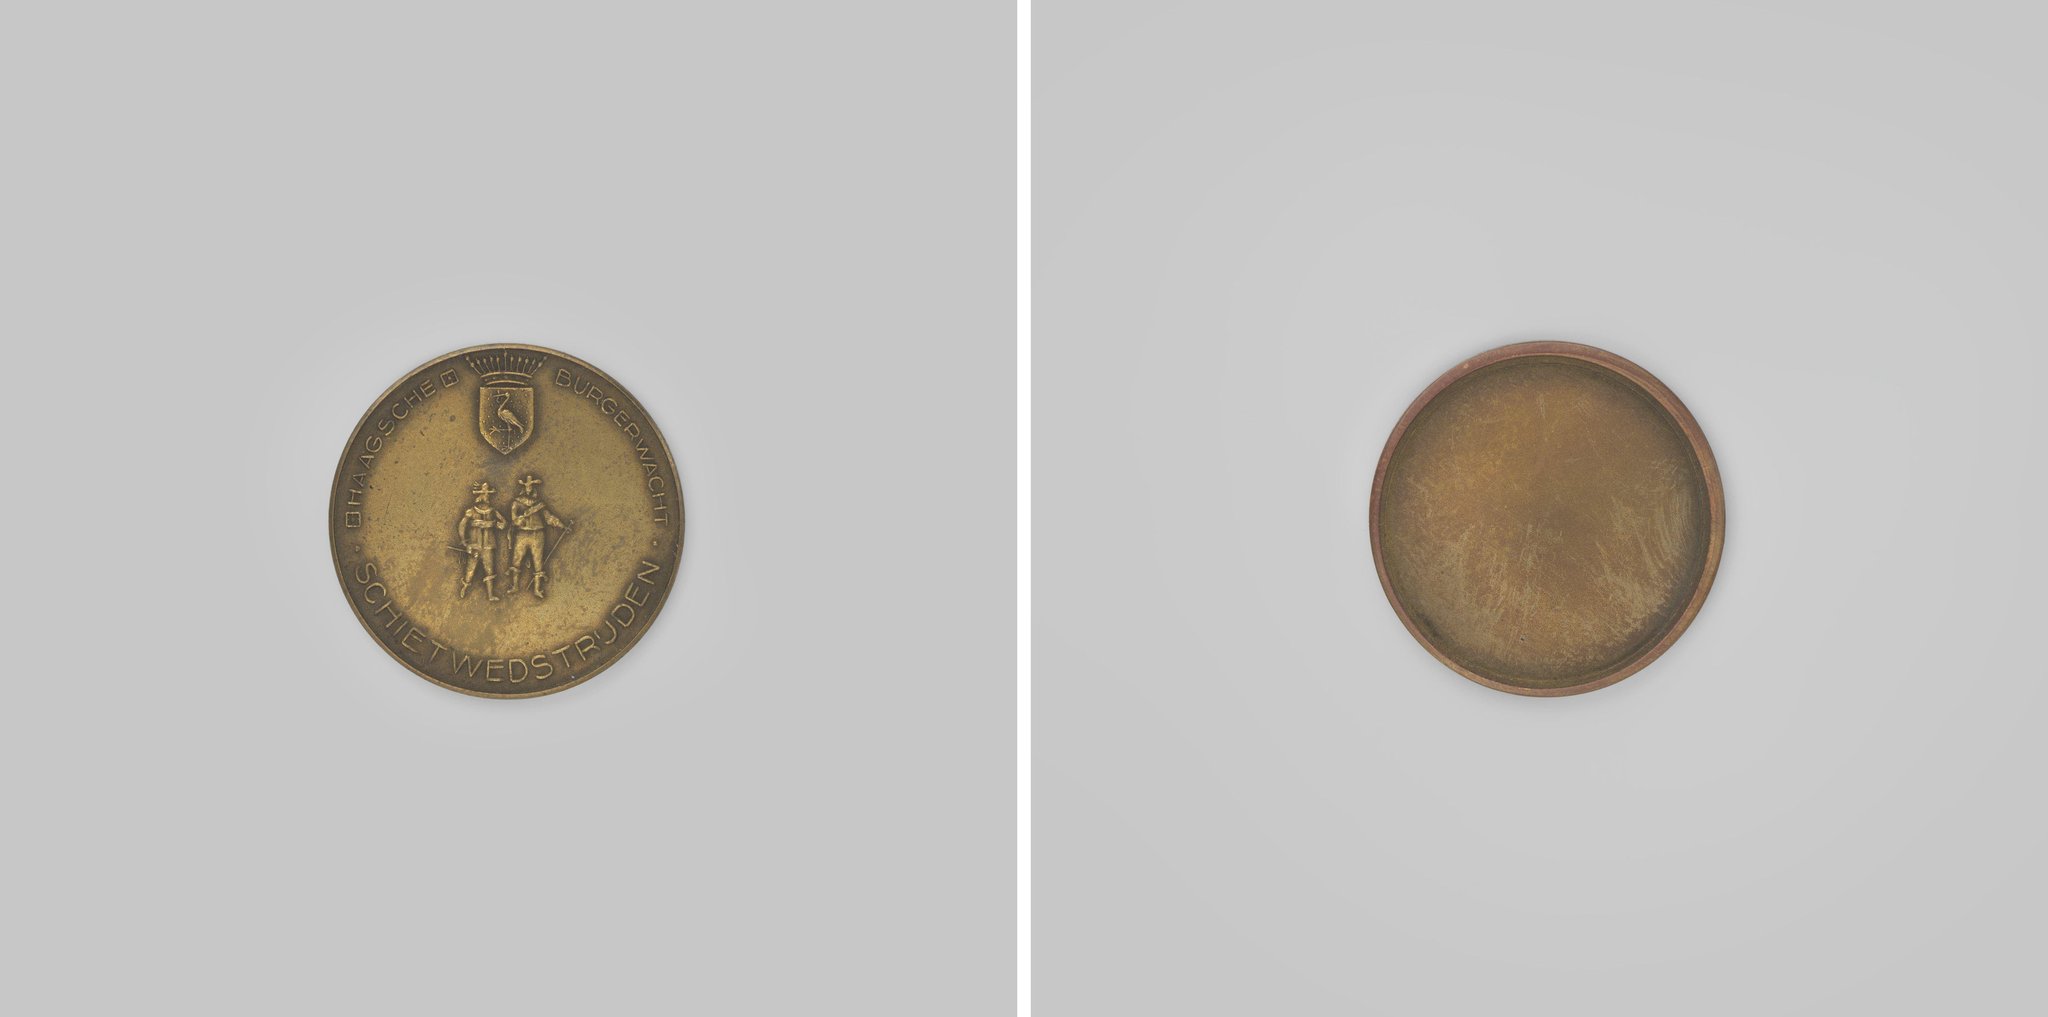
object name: history medal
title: Prijspenning schietwedstrijden burgerwacht te ’s Gravenhage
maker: Anonymous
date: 1920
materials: bronze